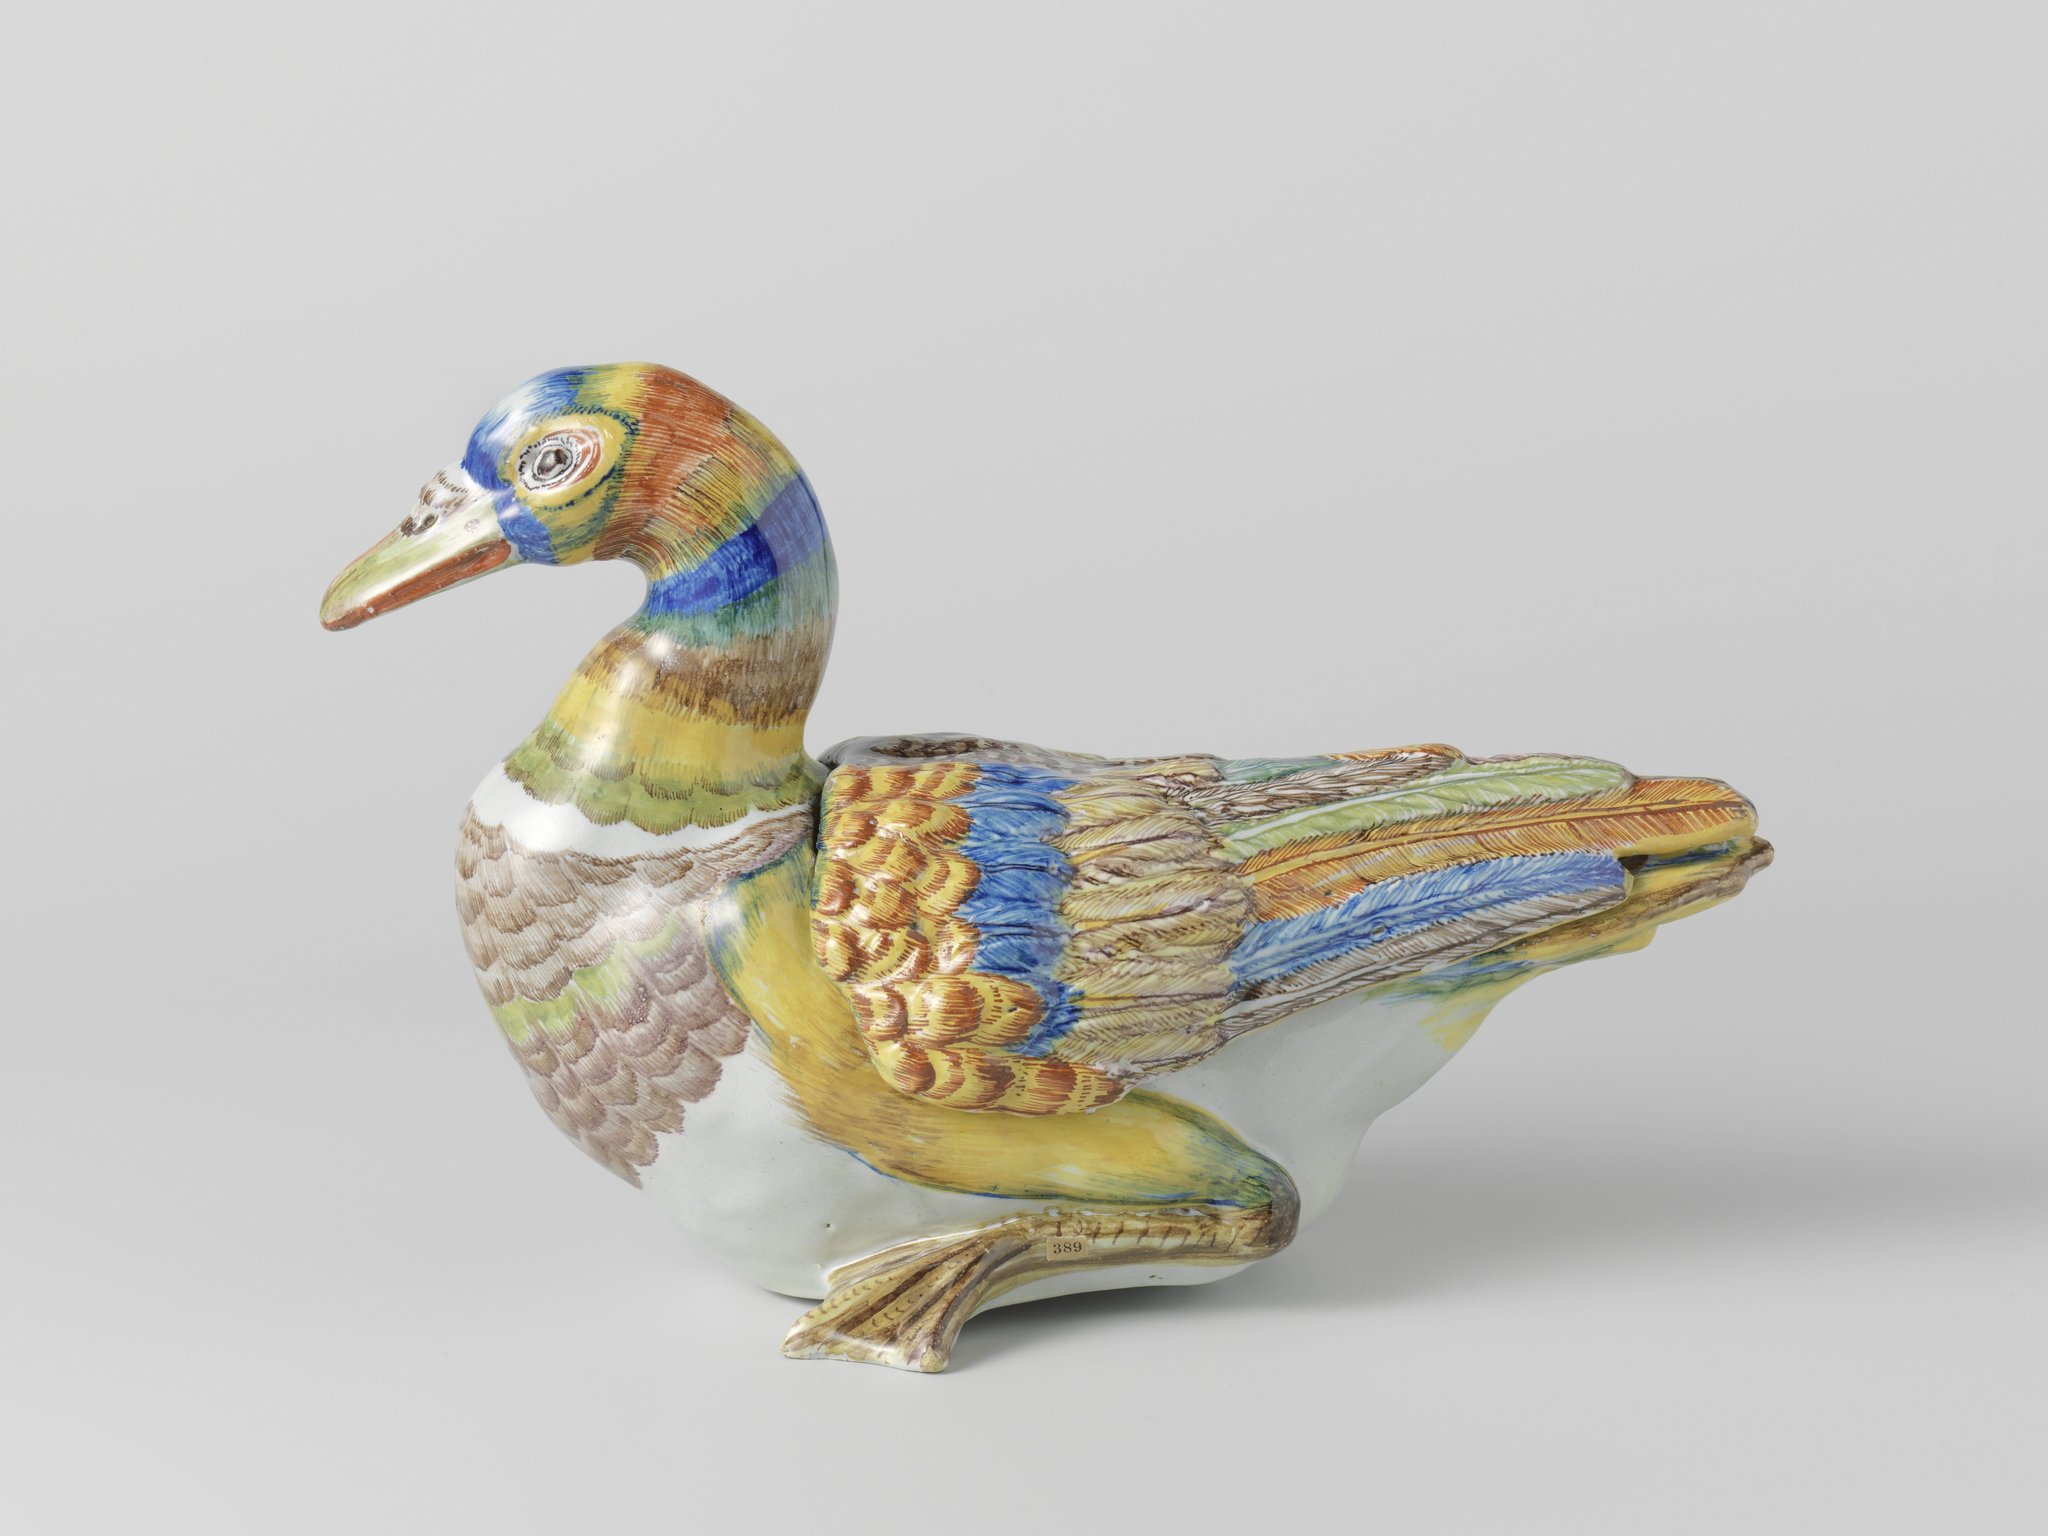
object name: tureen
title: Tureen in the form of a duck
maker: Anonymous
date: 1760-1775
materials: earthenware, glaze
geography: delft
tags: water-birds: duck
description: Terrine van faïence, in de vorm van een eend. Veelkleurig beschilderd.